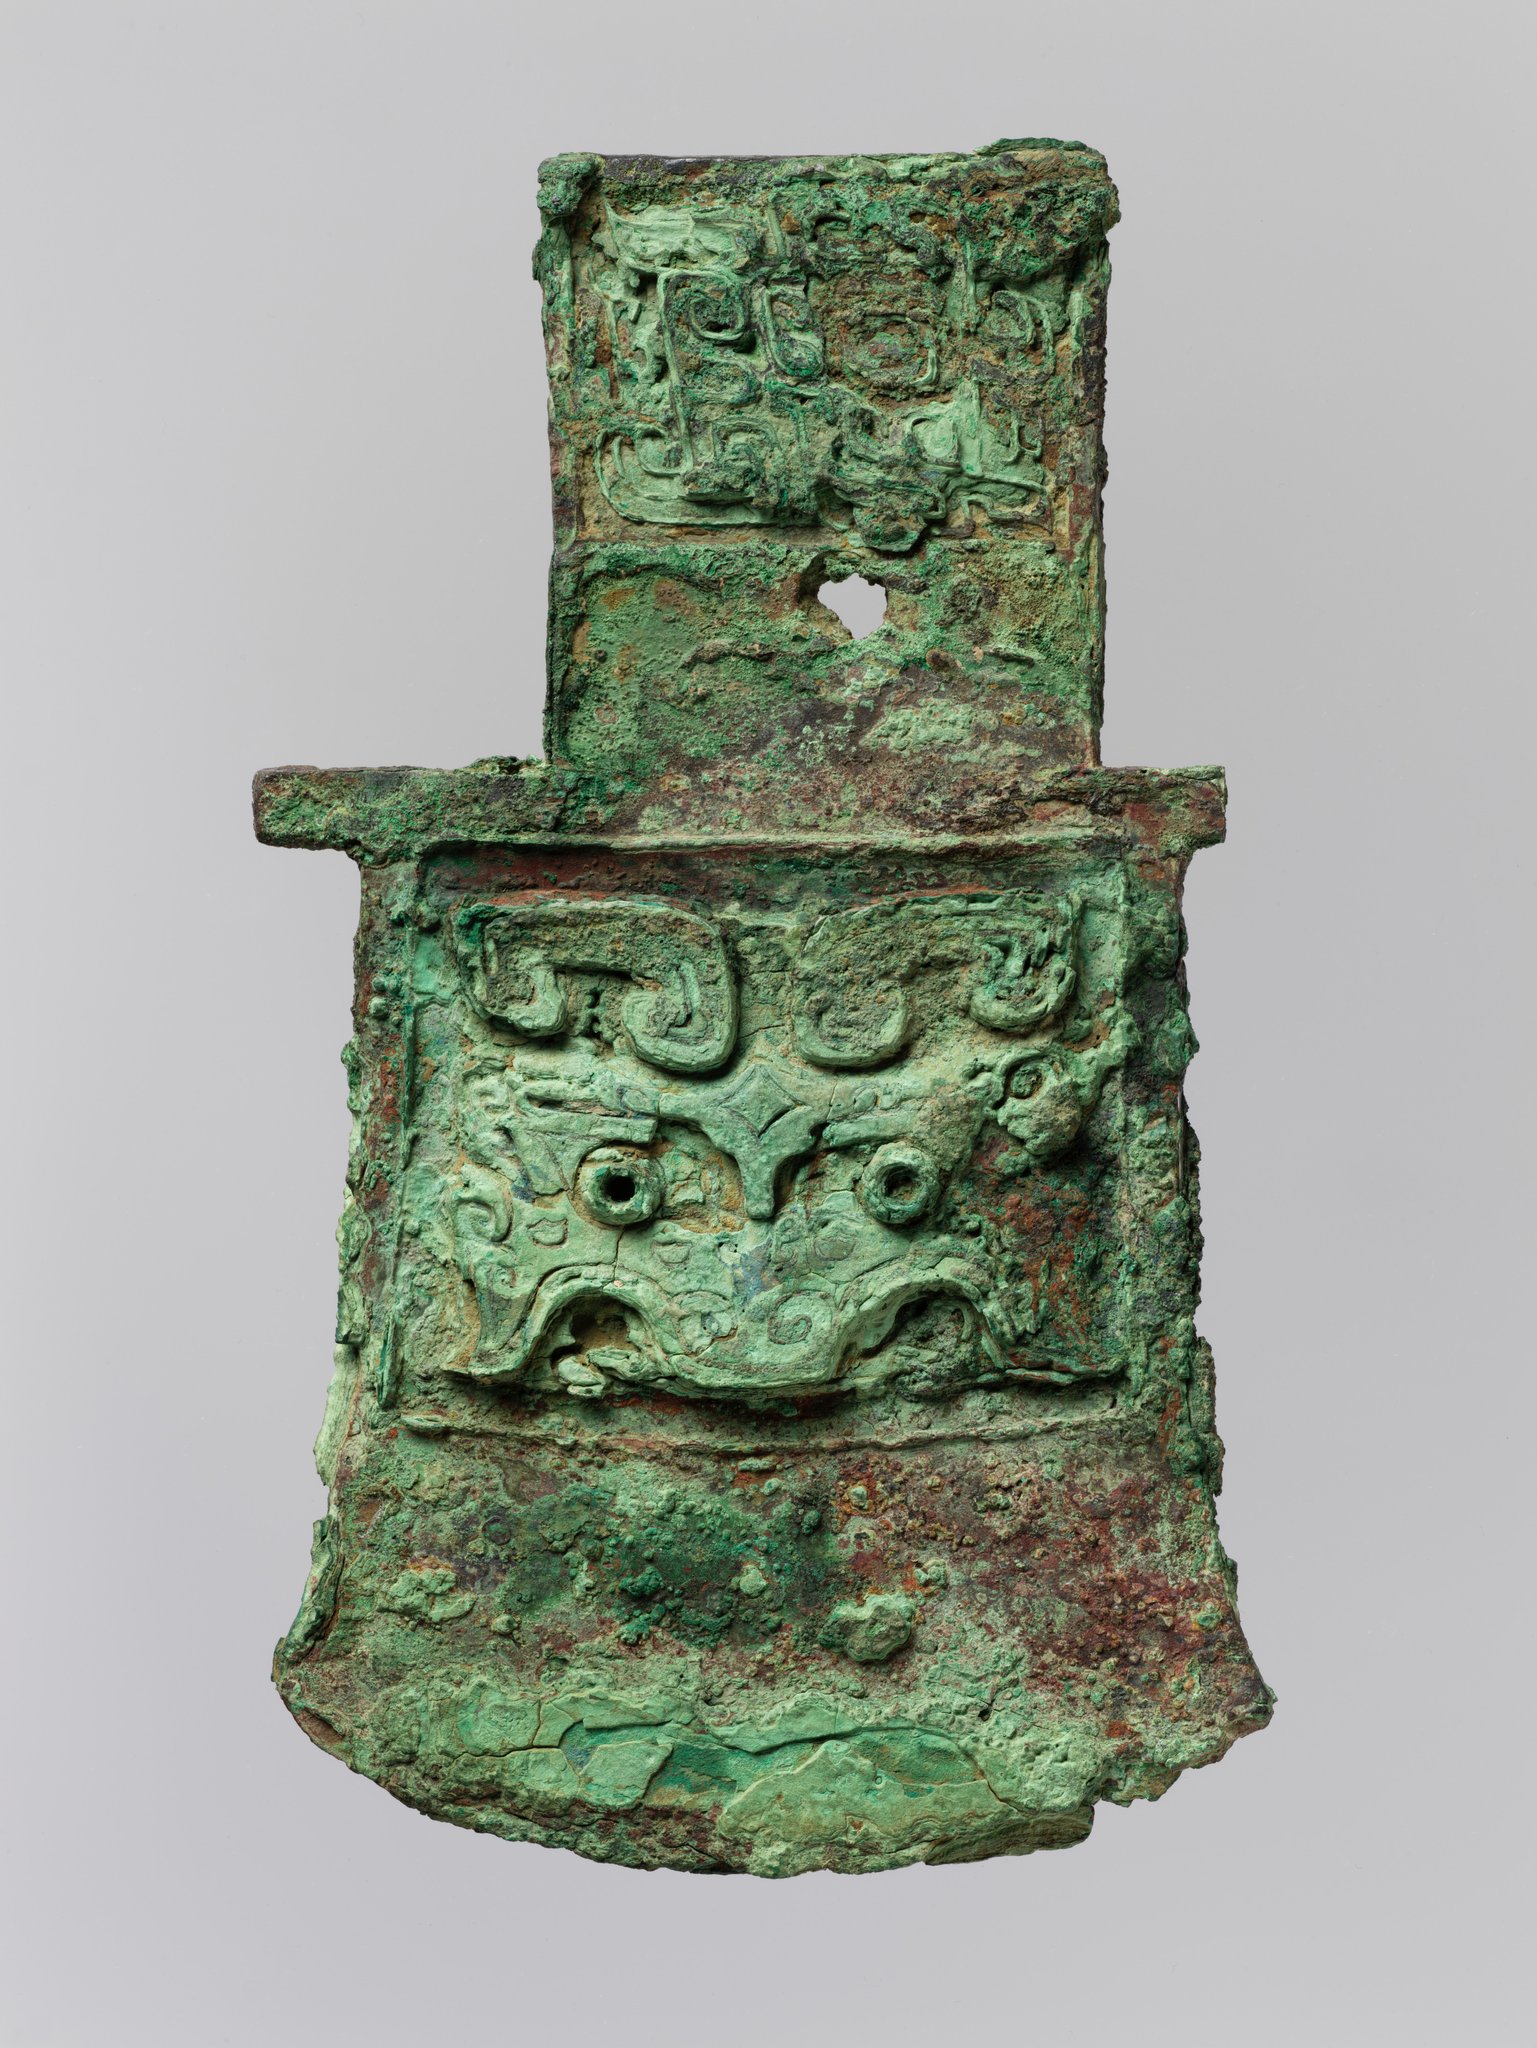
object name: axe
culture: chinese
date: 1300-1101 BCE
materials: bronze